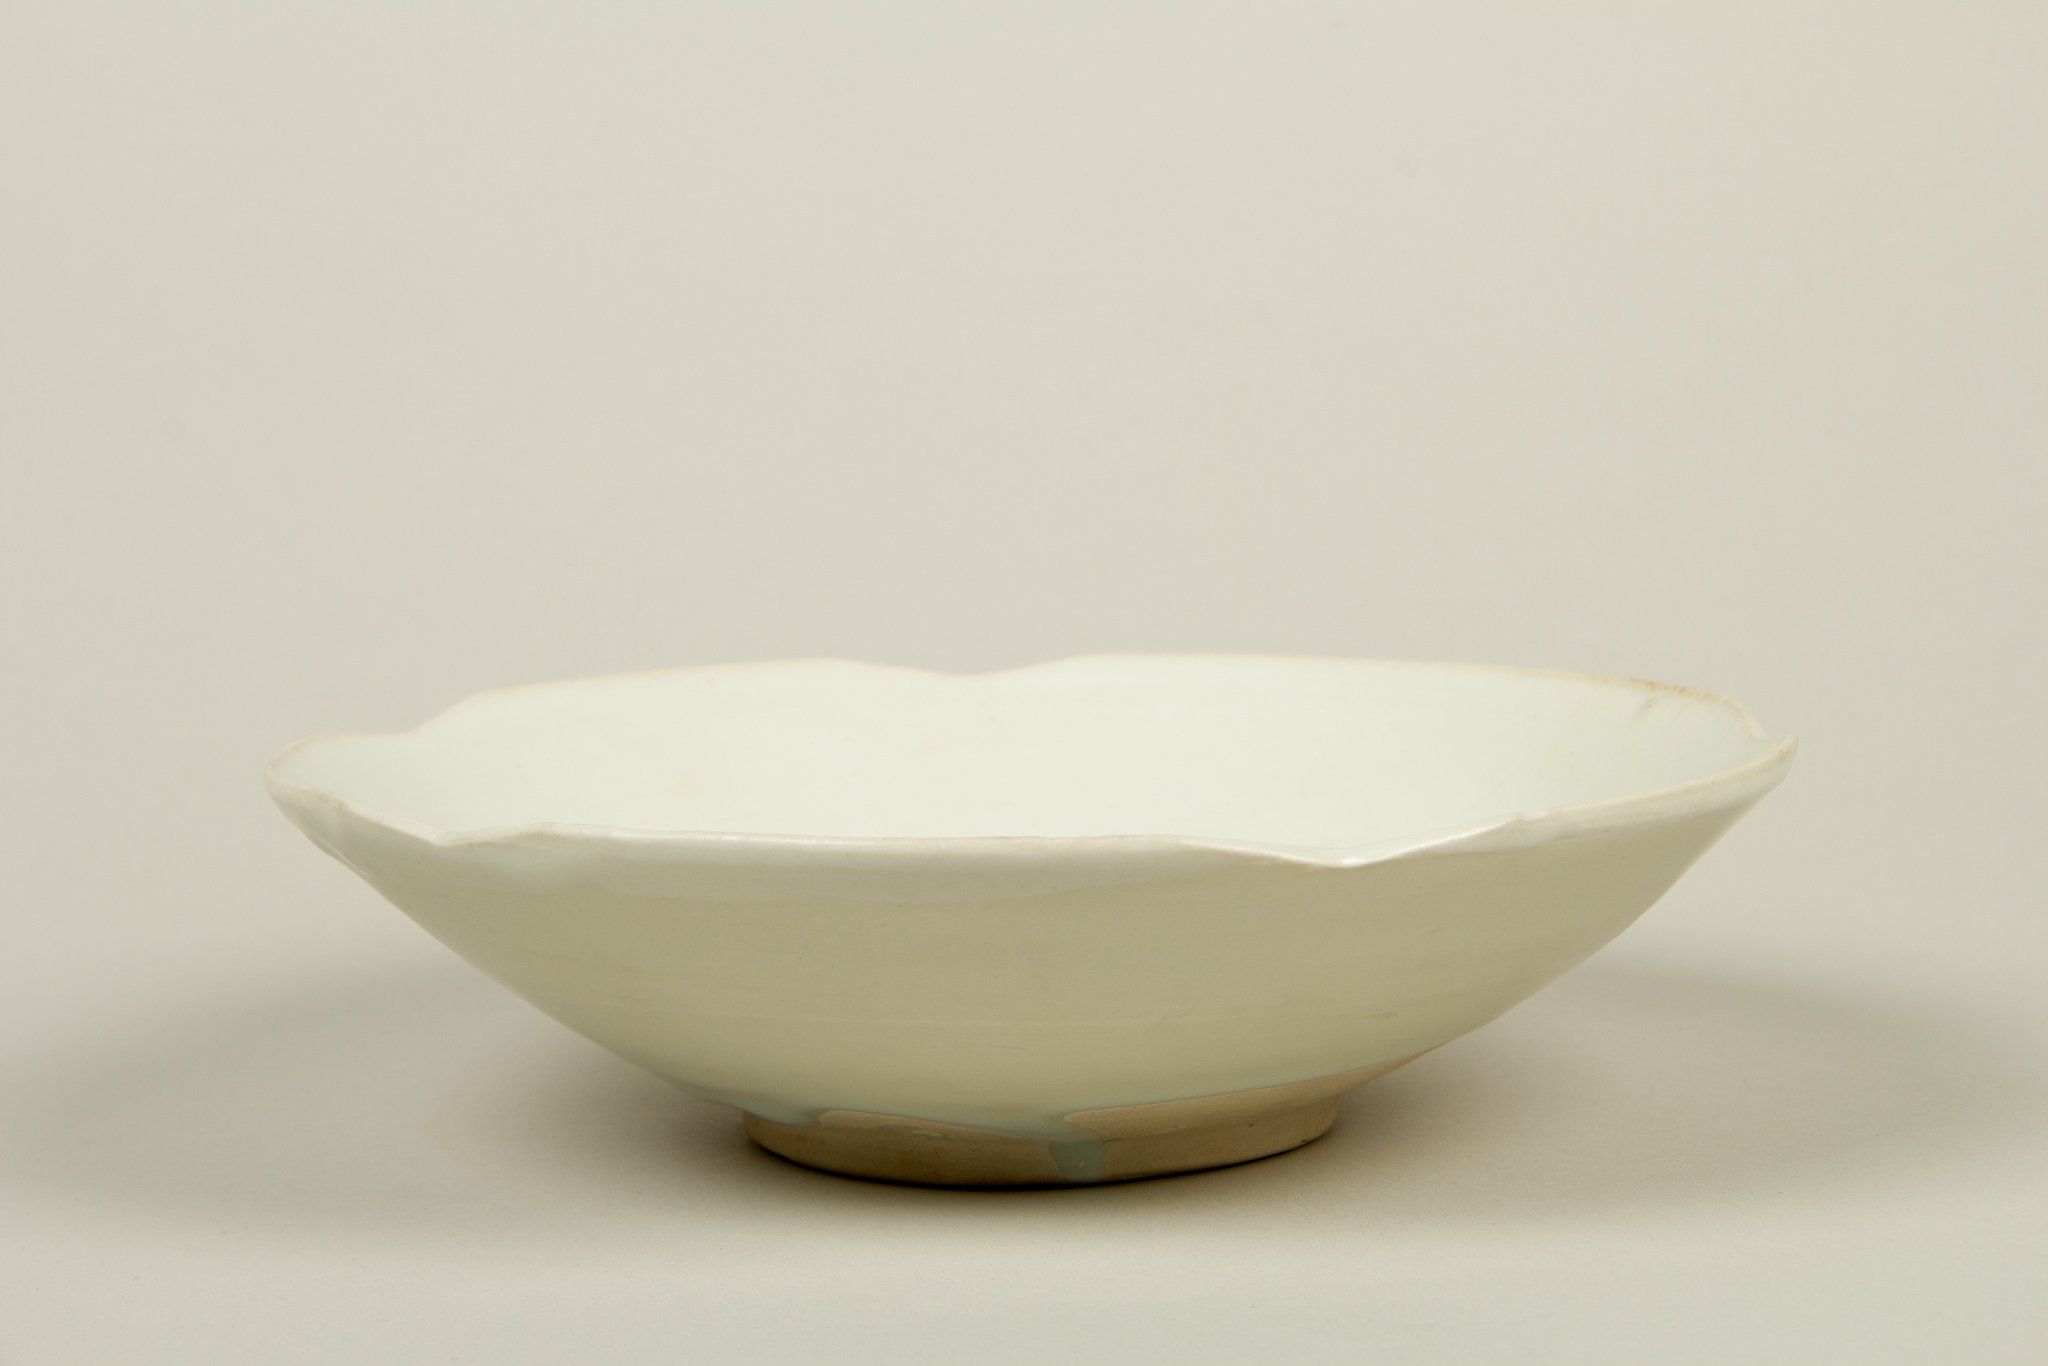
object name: bowl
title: Bowl with petal-shaped rim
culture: chinese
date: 801-900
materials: glaze, stoneware